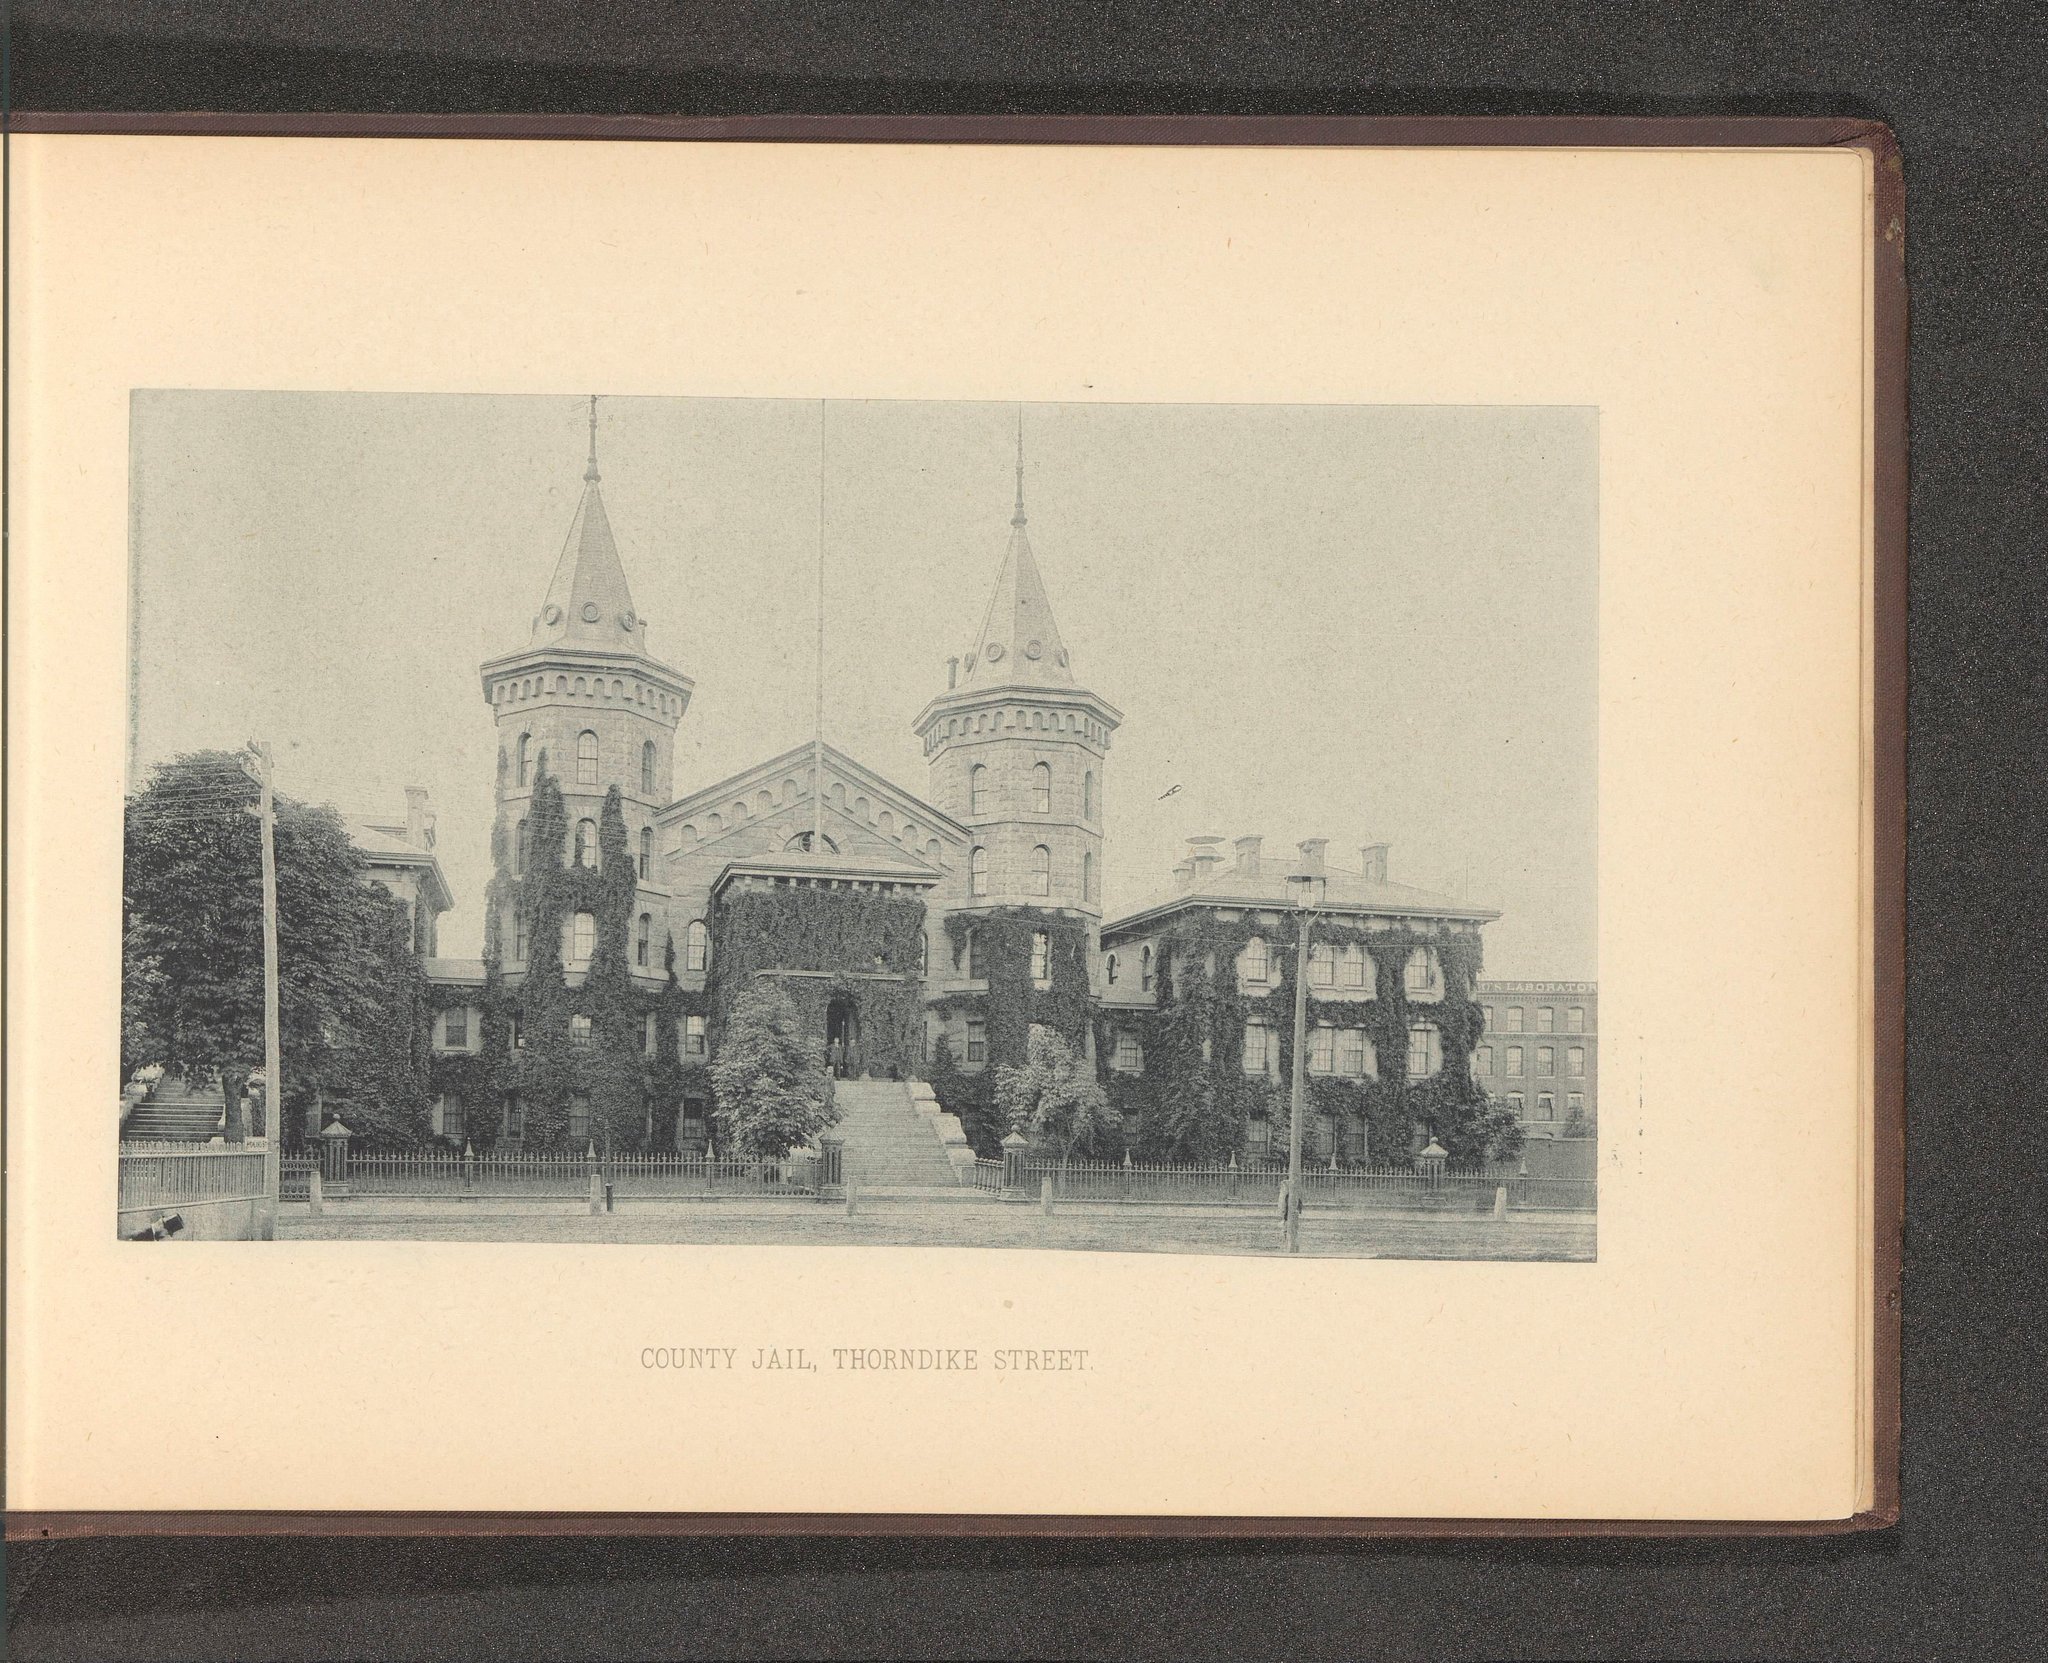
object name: page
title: County jail, Thorndike street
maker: Anonymous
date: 1887-1892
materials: paper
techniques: photograph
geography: lowell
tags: prison, jail, façade (of house or building)